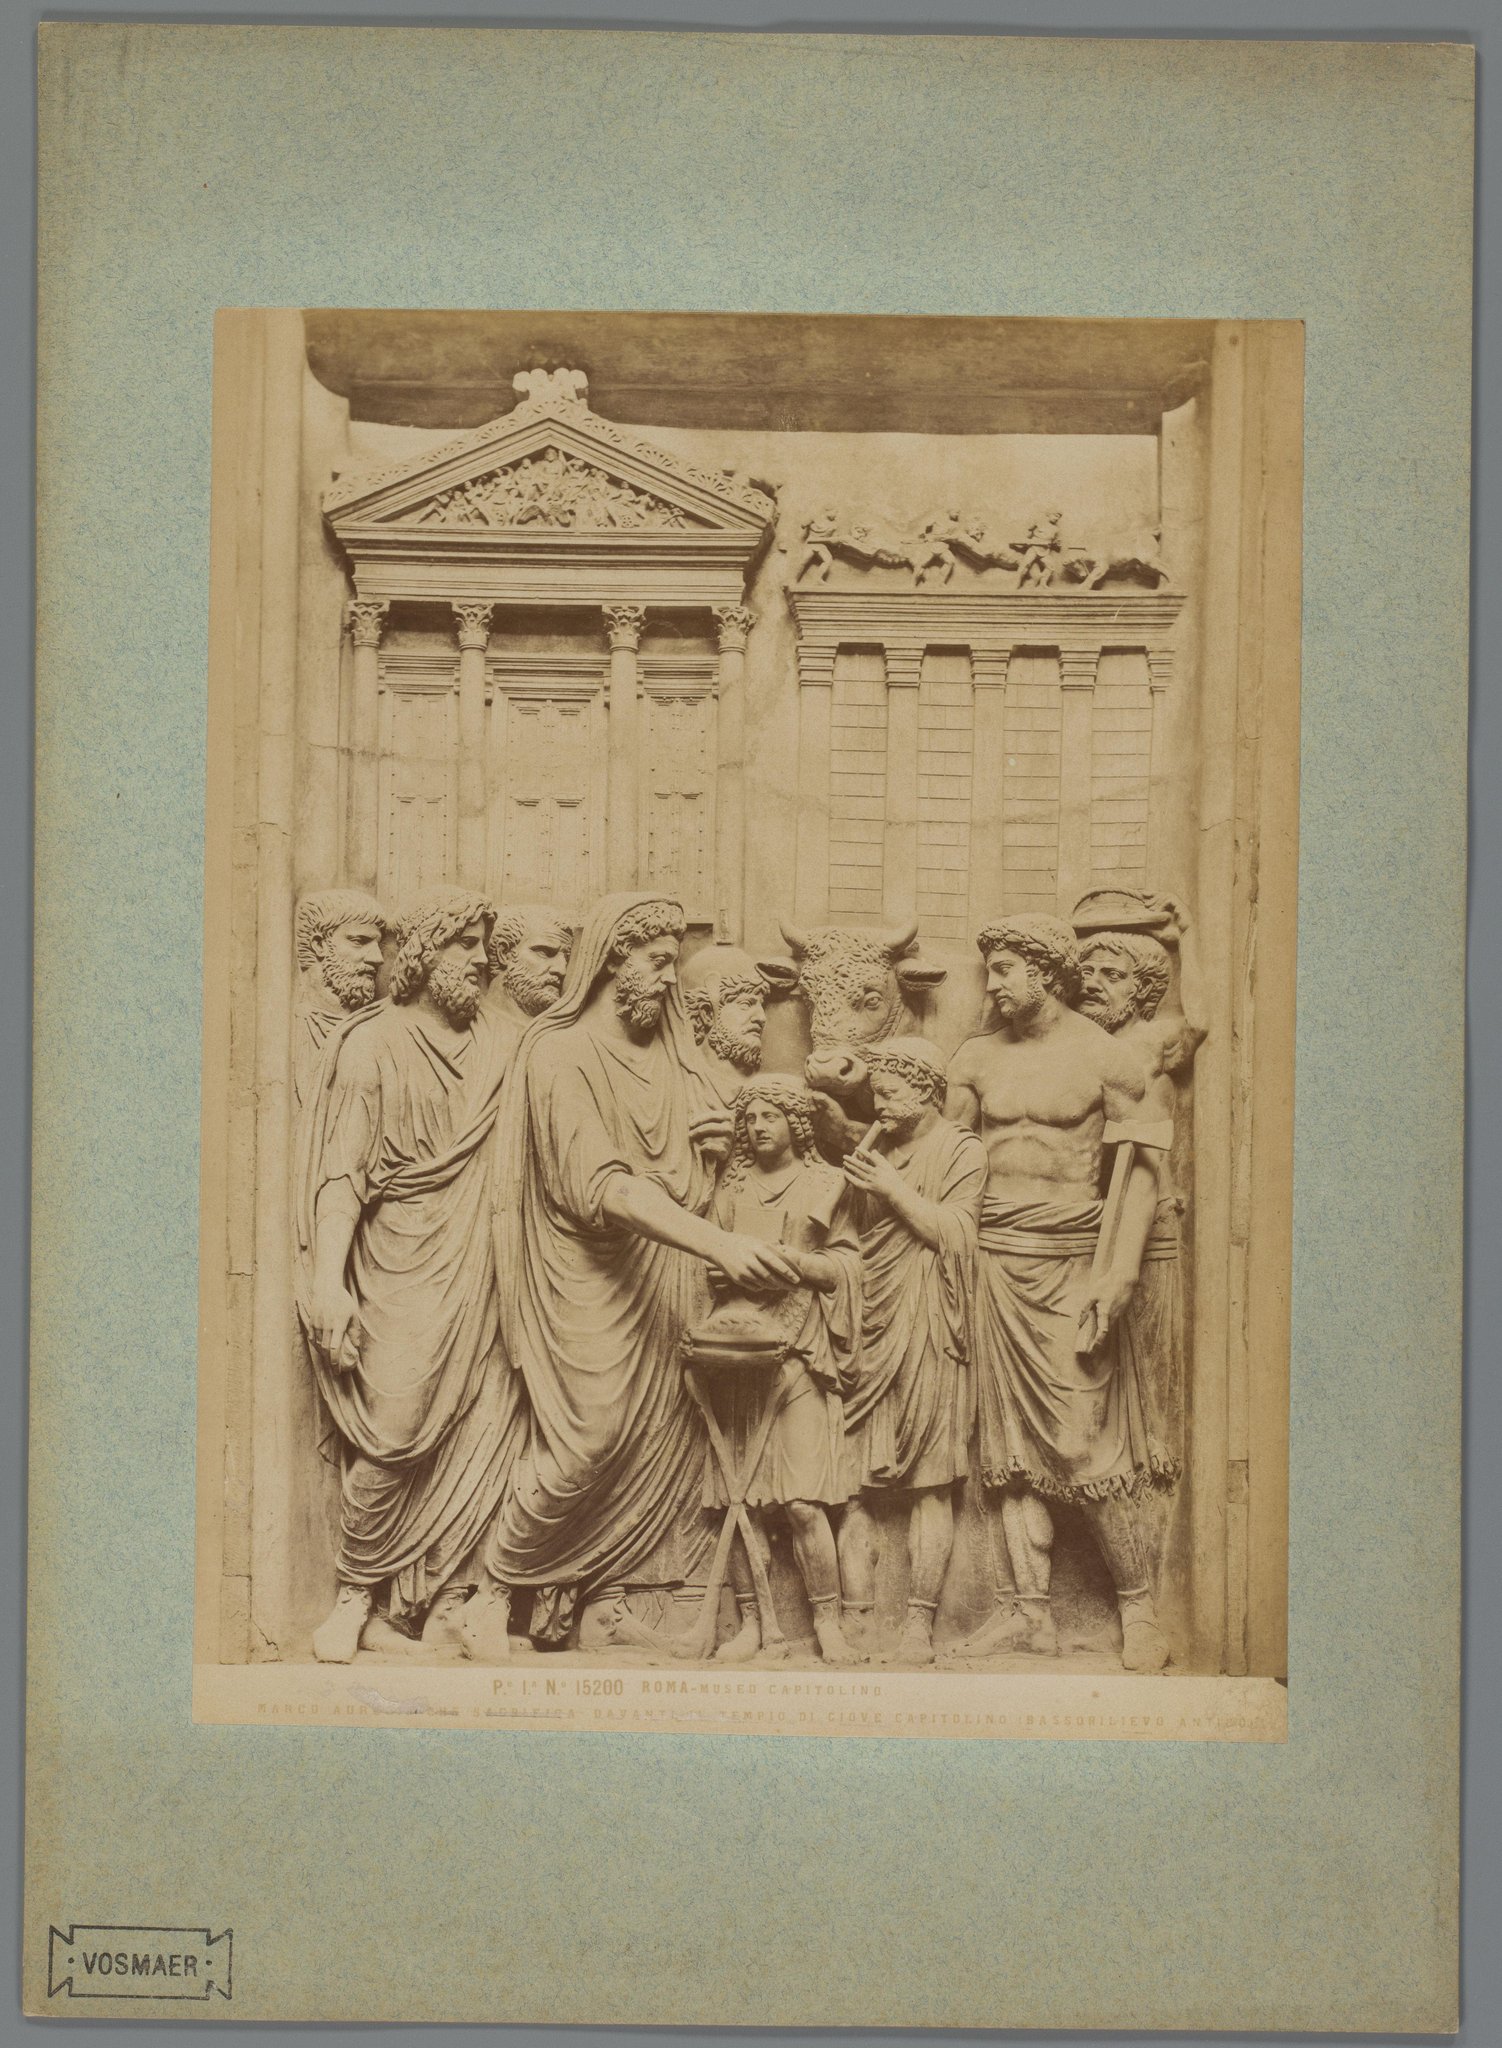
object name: photograph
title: Marco Aurelio che sacrifica davanti il tempio di Giove capitolino (bassorilievo antico)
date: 1852-1890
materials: cardboard, paper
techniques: albumen print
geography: rome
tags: rome, art (+ relief ~ sculpture)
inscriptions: number: ‘Pe.1a.No. 15200’, collector's mark: ‘VOSMAER’